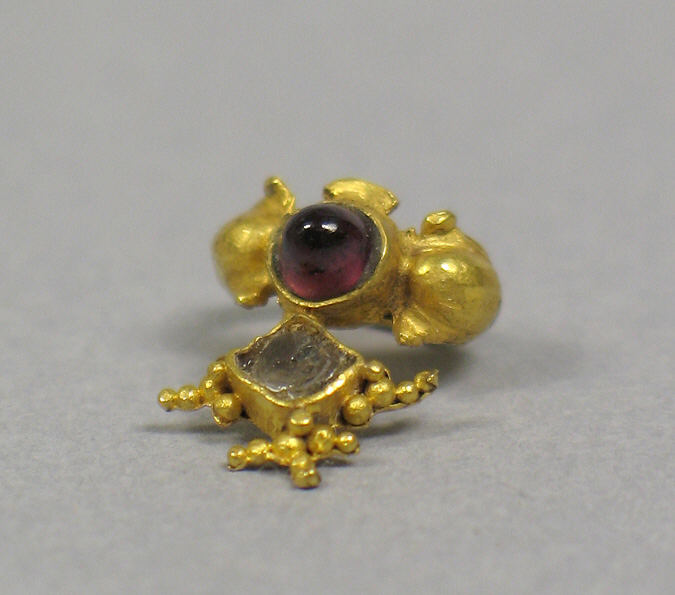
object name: pair of ear ornament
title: Pair of Ear Ornaments, Ruby and Crystal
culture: indonesian, central java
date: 701-1200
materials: gold